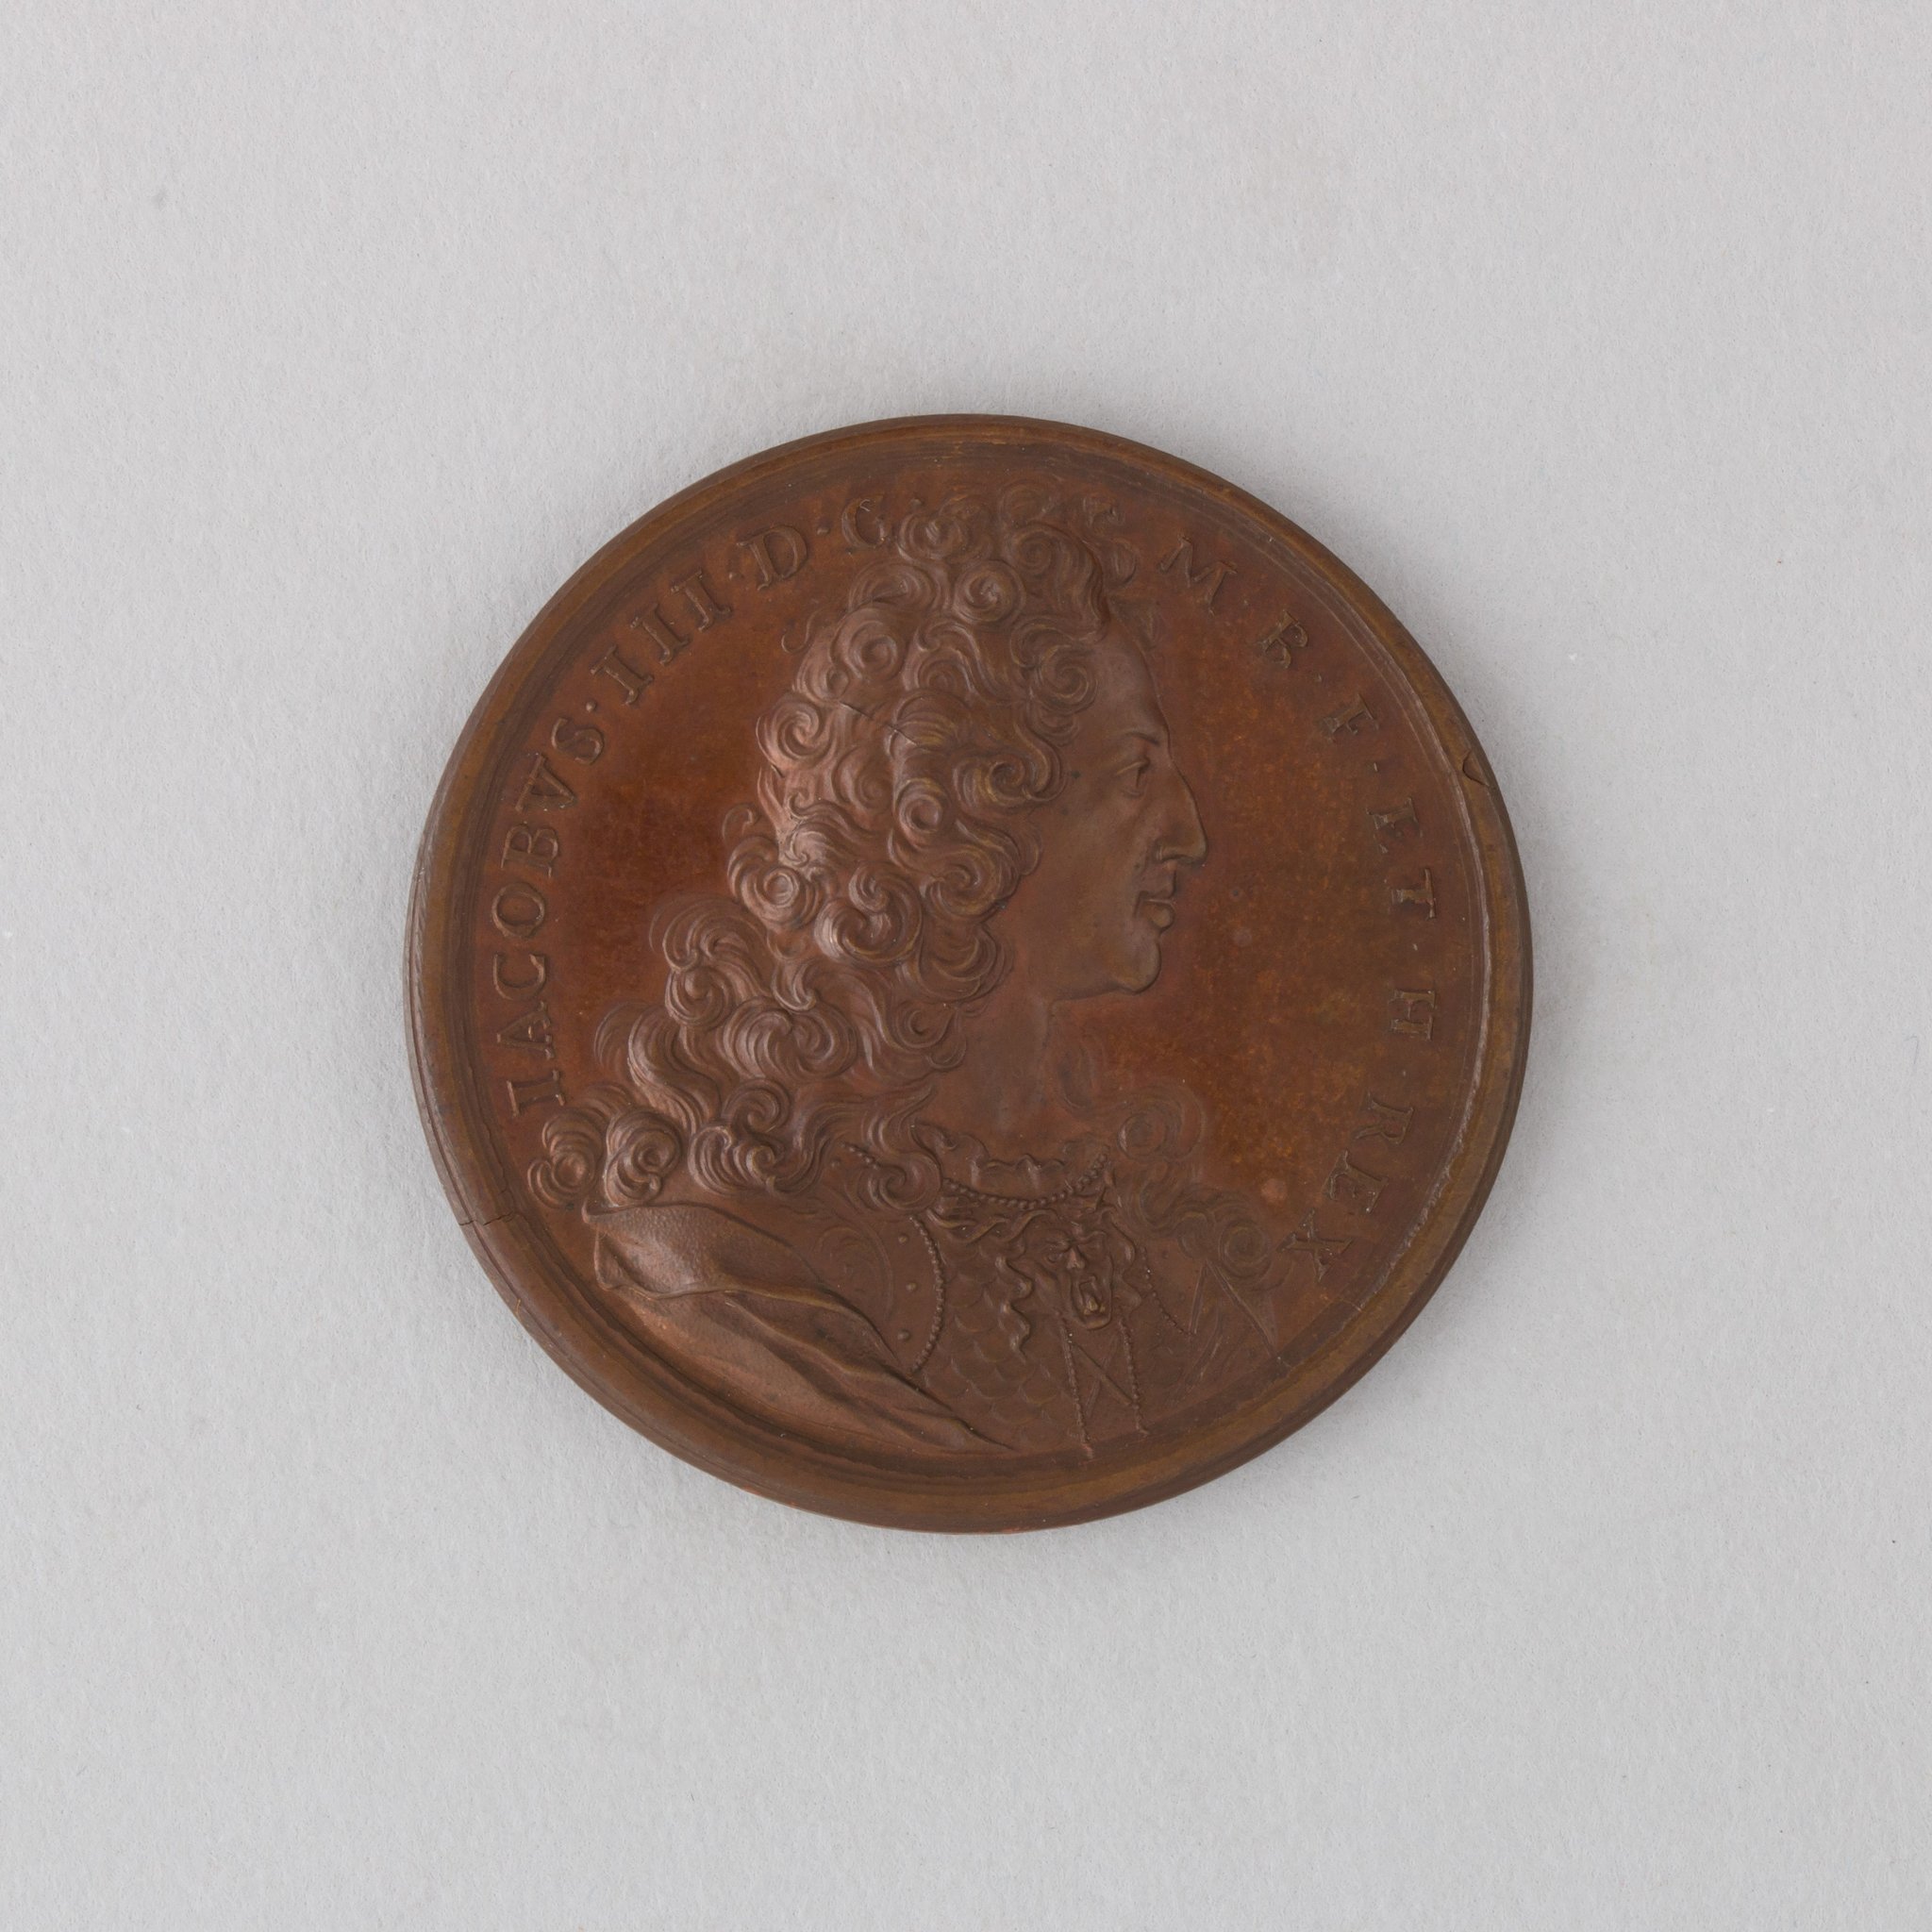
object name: medal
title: Medal Commemorating the Marriage of James III and Princess Clementina, 1719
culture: british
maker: ottone hamerani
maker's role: artist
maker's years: 1694-1768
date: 1719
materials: bronze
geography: england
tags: men,profiles,women